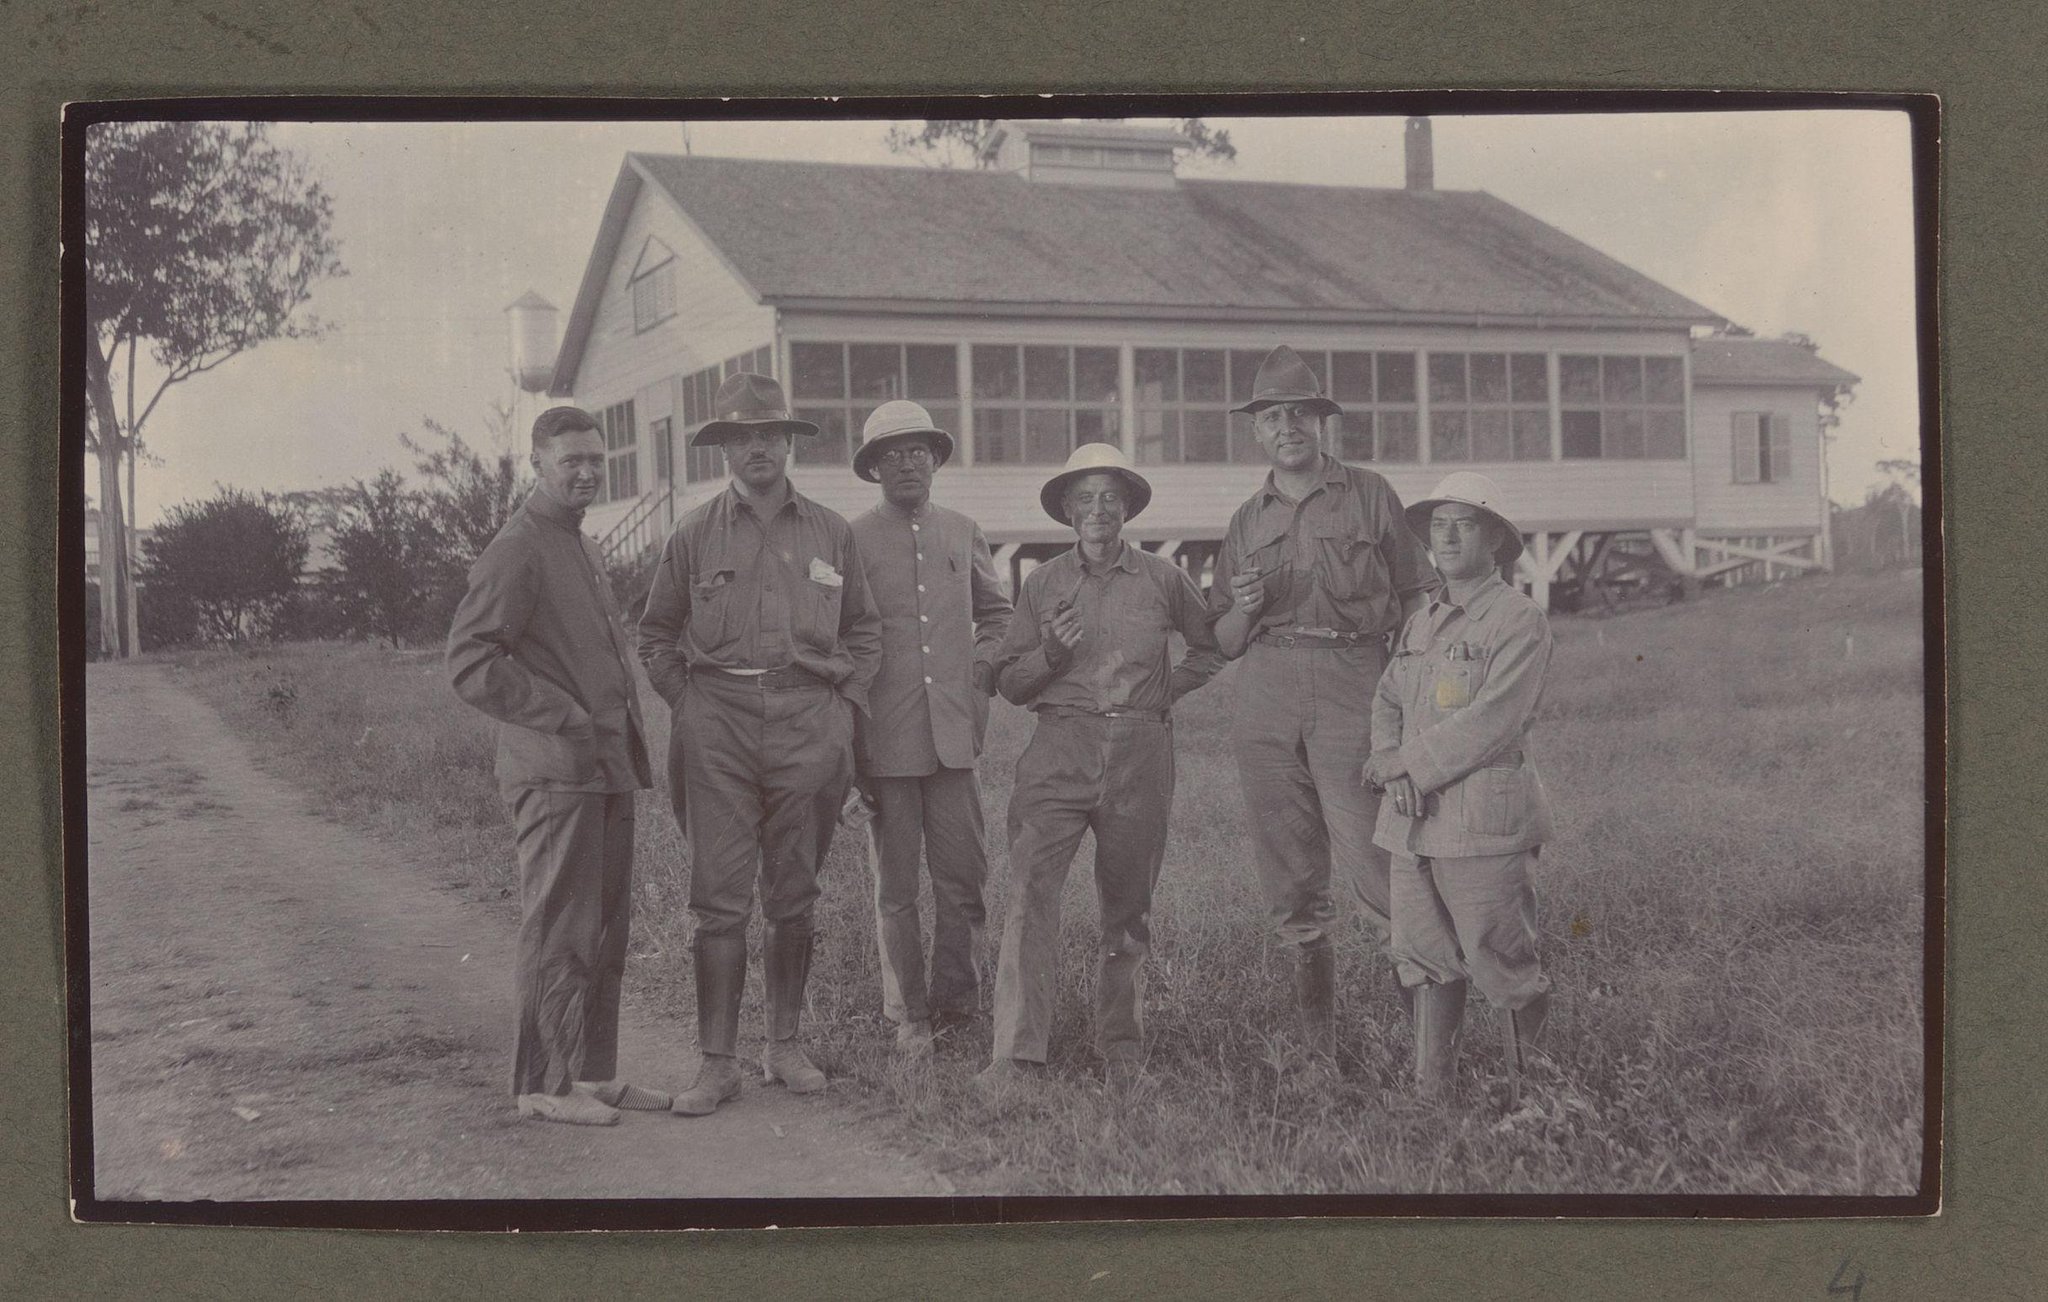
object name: photograph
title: Groepsfoto van zes mannen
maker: Anonymous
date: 1911-1925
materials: photographic support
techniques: photography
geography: suriname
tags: jetten, familie, moengo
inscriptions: inscription: ‘Nov '25 / ... work is finished’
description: Foto van een groep van zes mannen voor een huis te Moengo, in het midden R.A. Jetten. Foto op een bladzijde van een los albumblad. Onderdeel van het ensemble met foto's van de familie van ingenieur Jetten in de mijnbouwstad Moengo in Suriname.